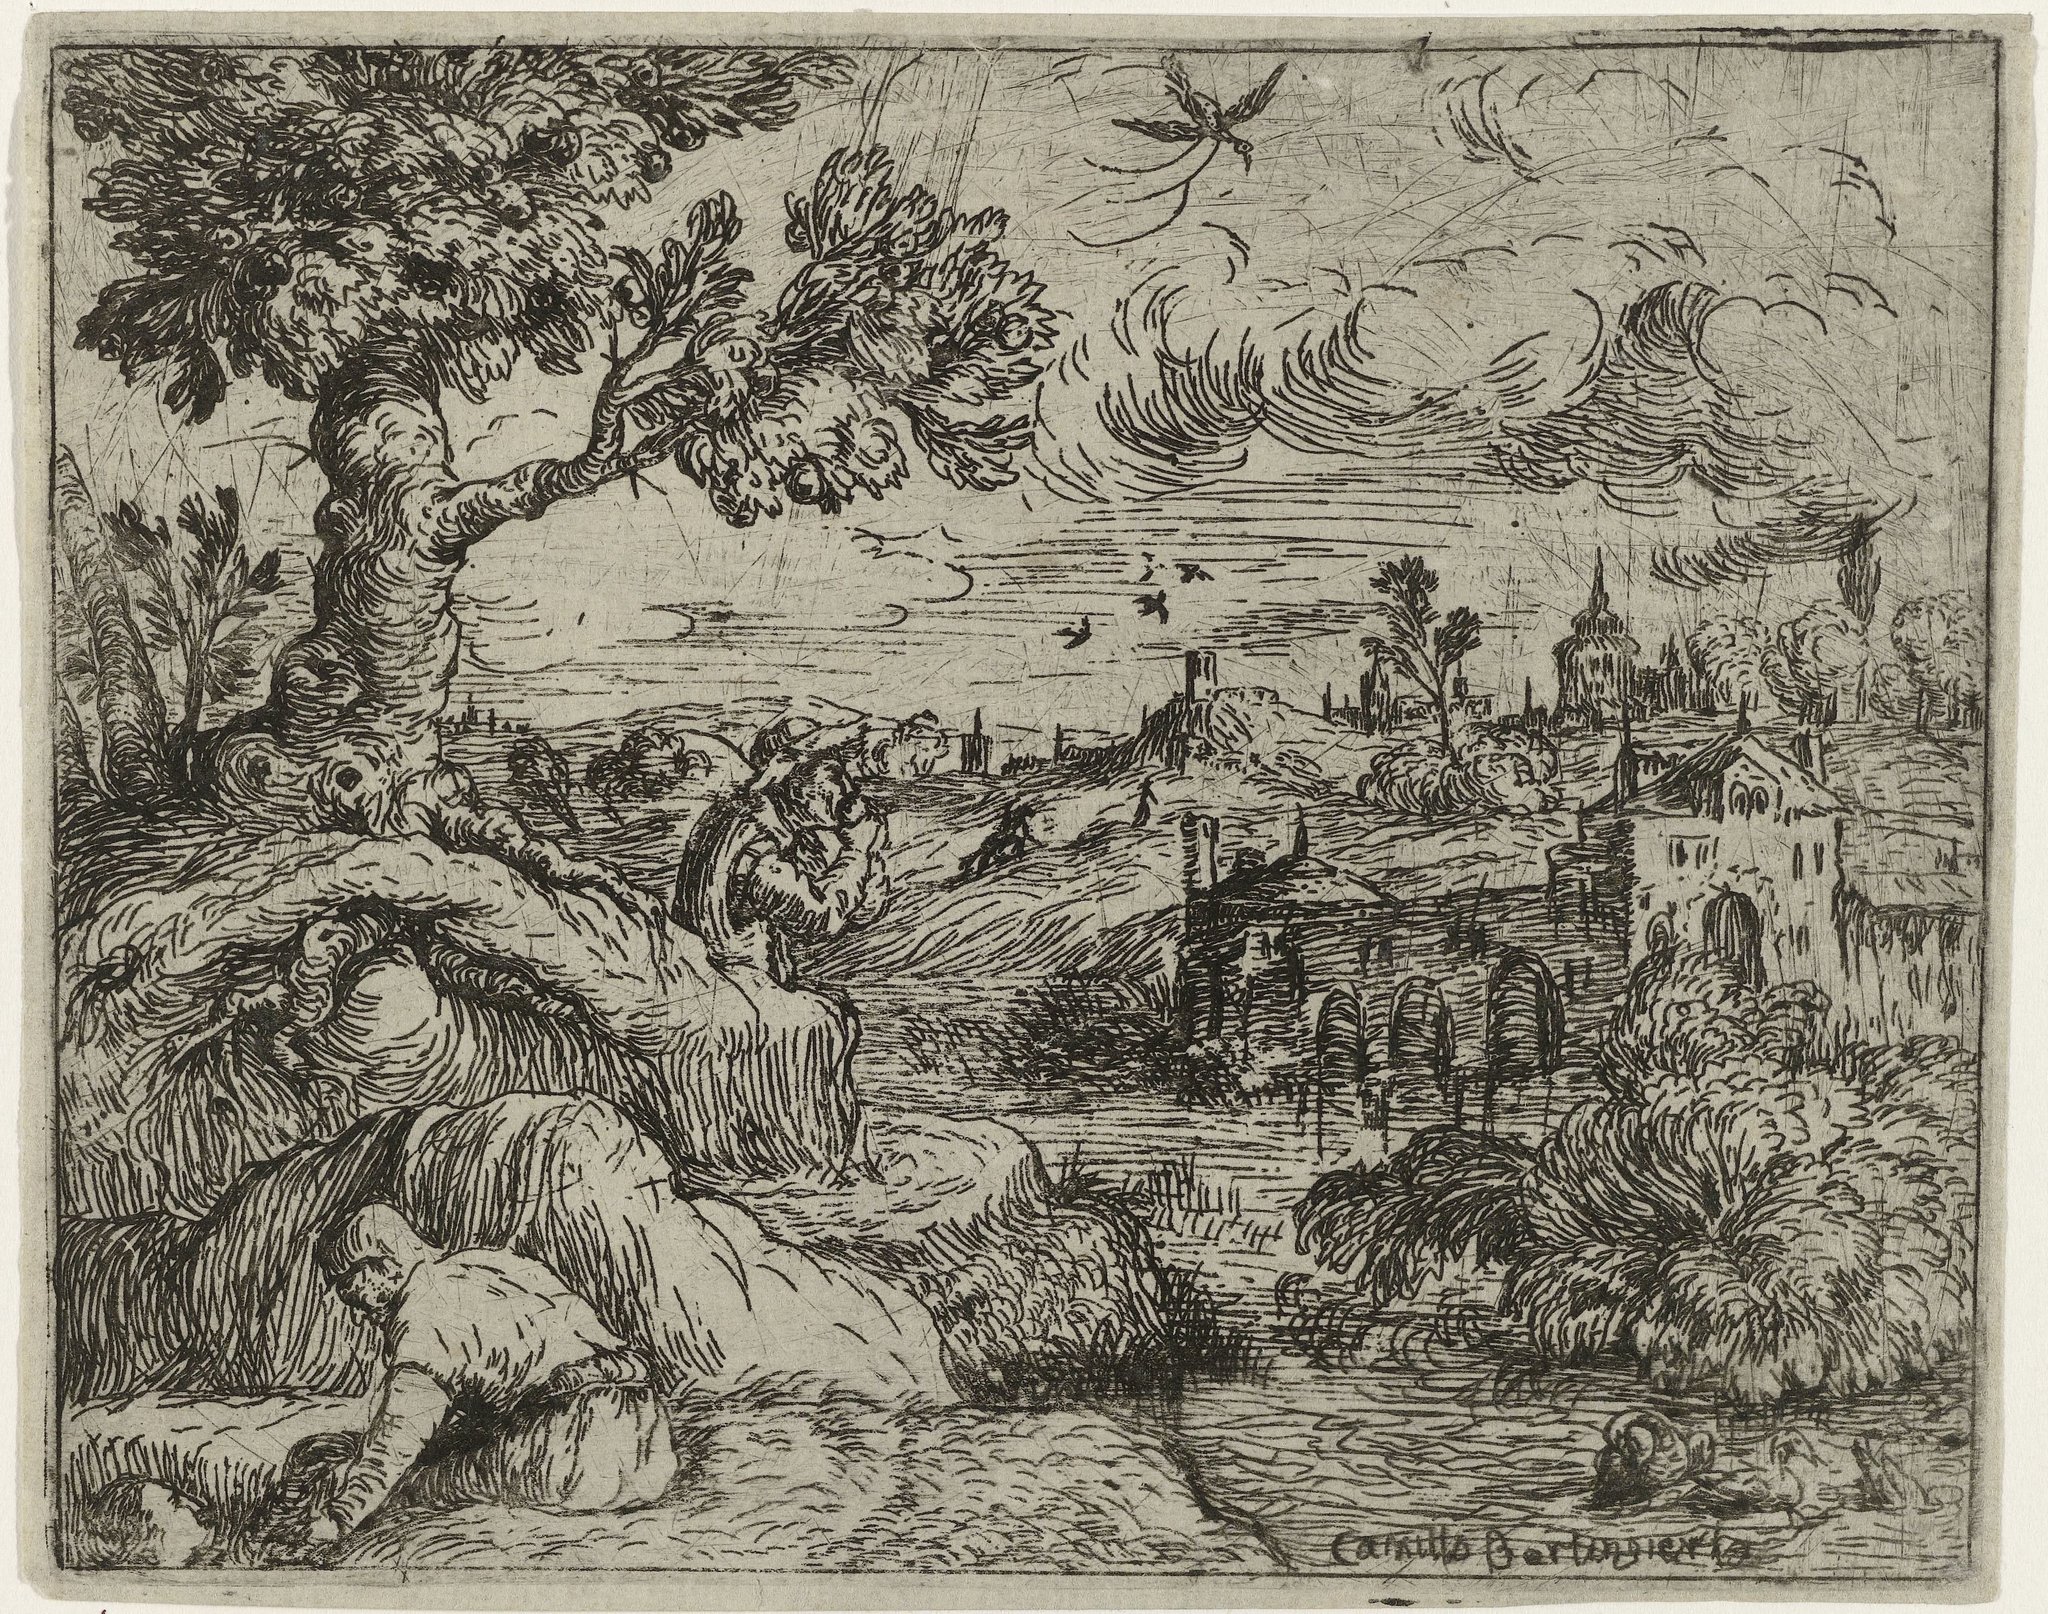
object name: print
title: Landschap met bewolkte hemel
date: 1606-1635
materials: paper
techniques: etching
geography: venice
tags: landscapes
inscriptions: collector's mark: Lugt 2228, inscription: ‘G. Storck a Milano 1805, In N 14131.’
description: Landschap met langs een dorp stromende rivier. Links een etende man onder een boom. Links op de voorgrond wordt een vrouw door een man uit een kuil of put geholpen.